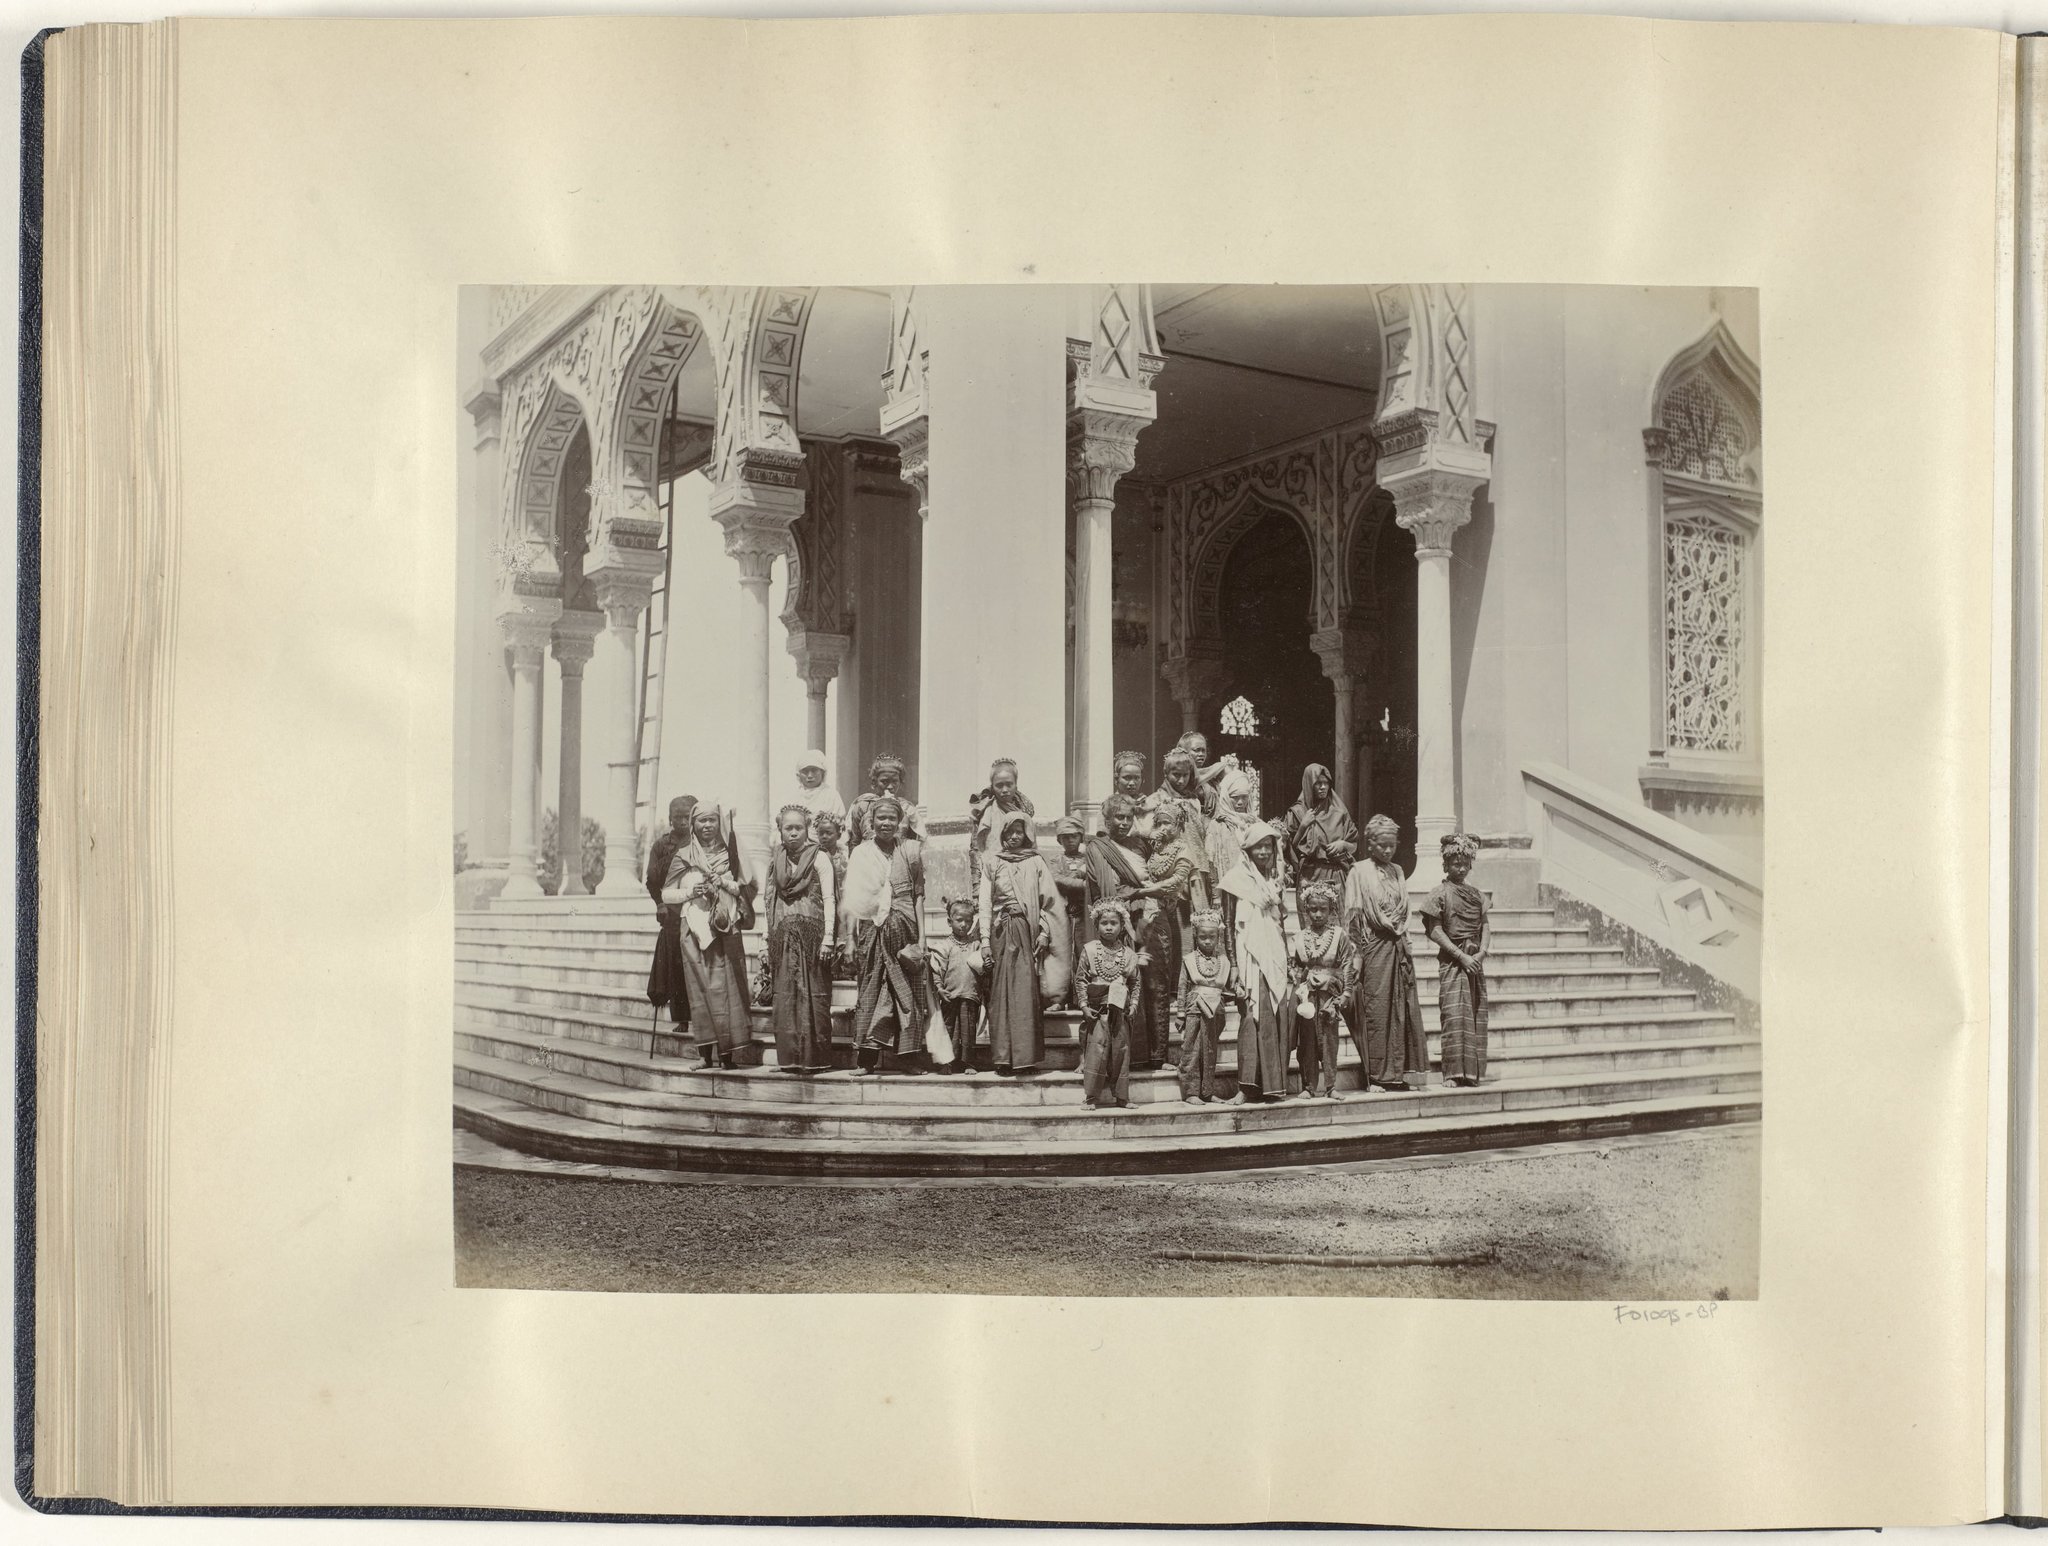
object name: photograph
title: Groepsportret van Indische vrouwen en kinderen op de trappen van de grote moskee van Banda Atjeh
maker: Anonymous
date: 1895-1905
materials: paper, photographic support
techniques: albumen print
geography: banda atjeh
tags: mother and baby or young child, temple, shrine ~ islam, mohammedanism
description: Onderdeel van Reisalbum met foto's van bezienswaardigheden in Italië, Zwitserland en Nederlands-Indië.